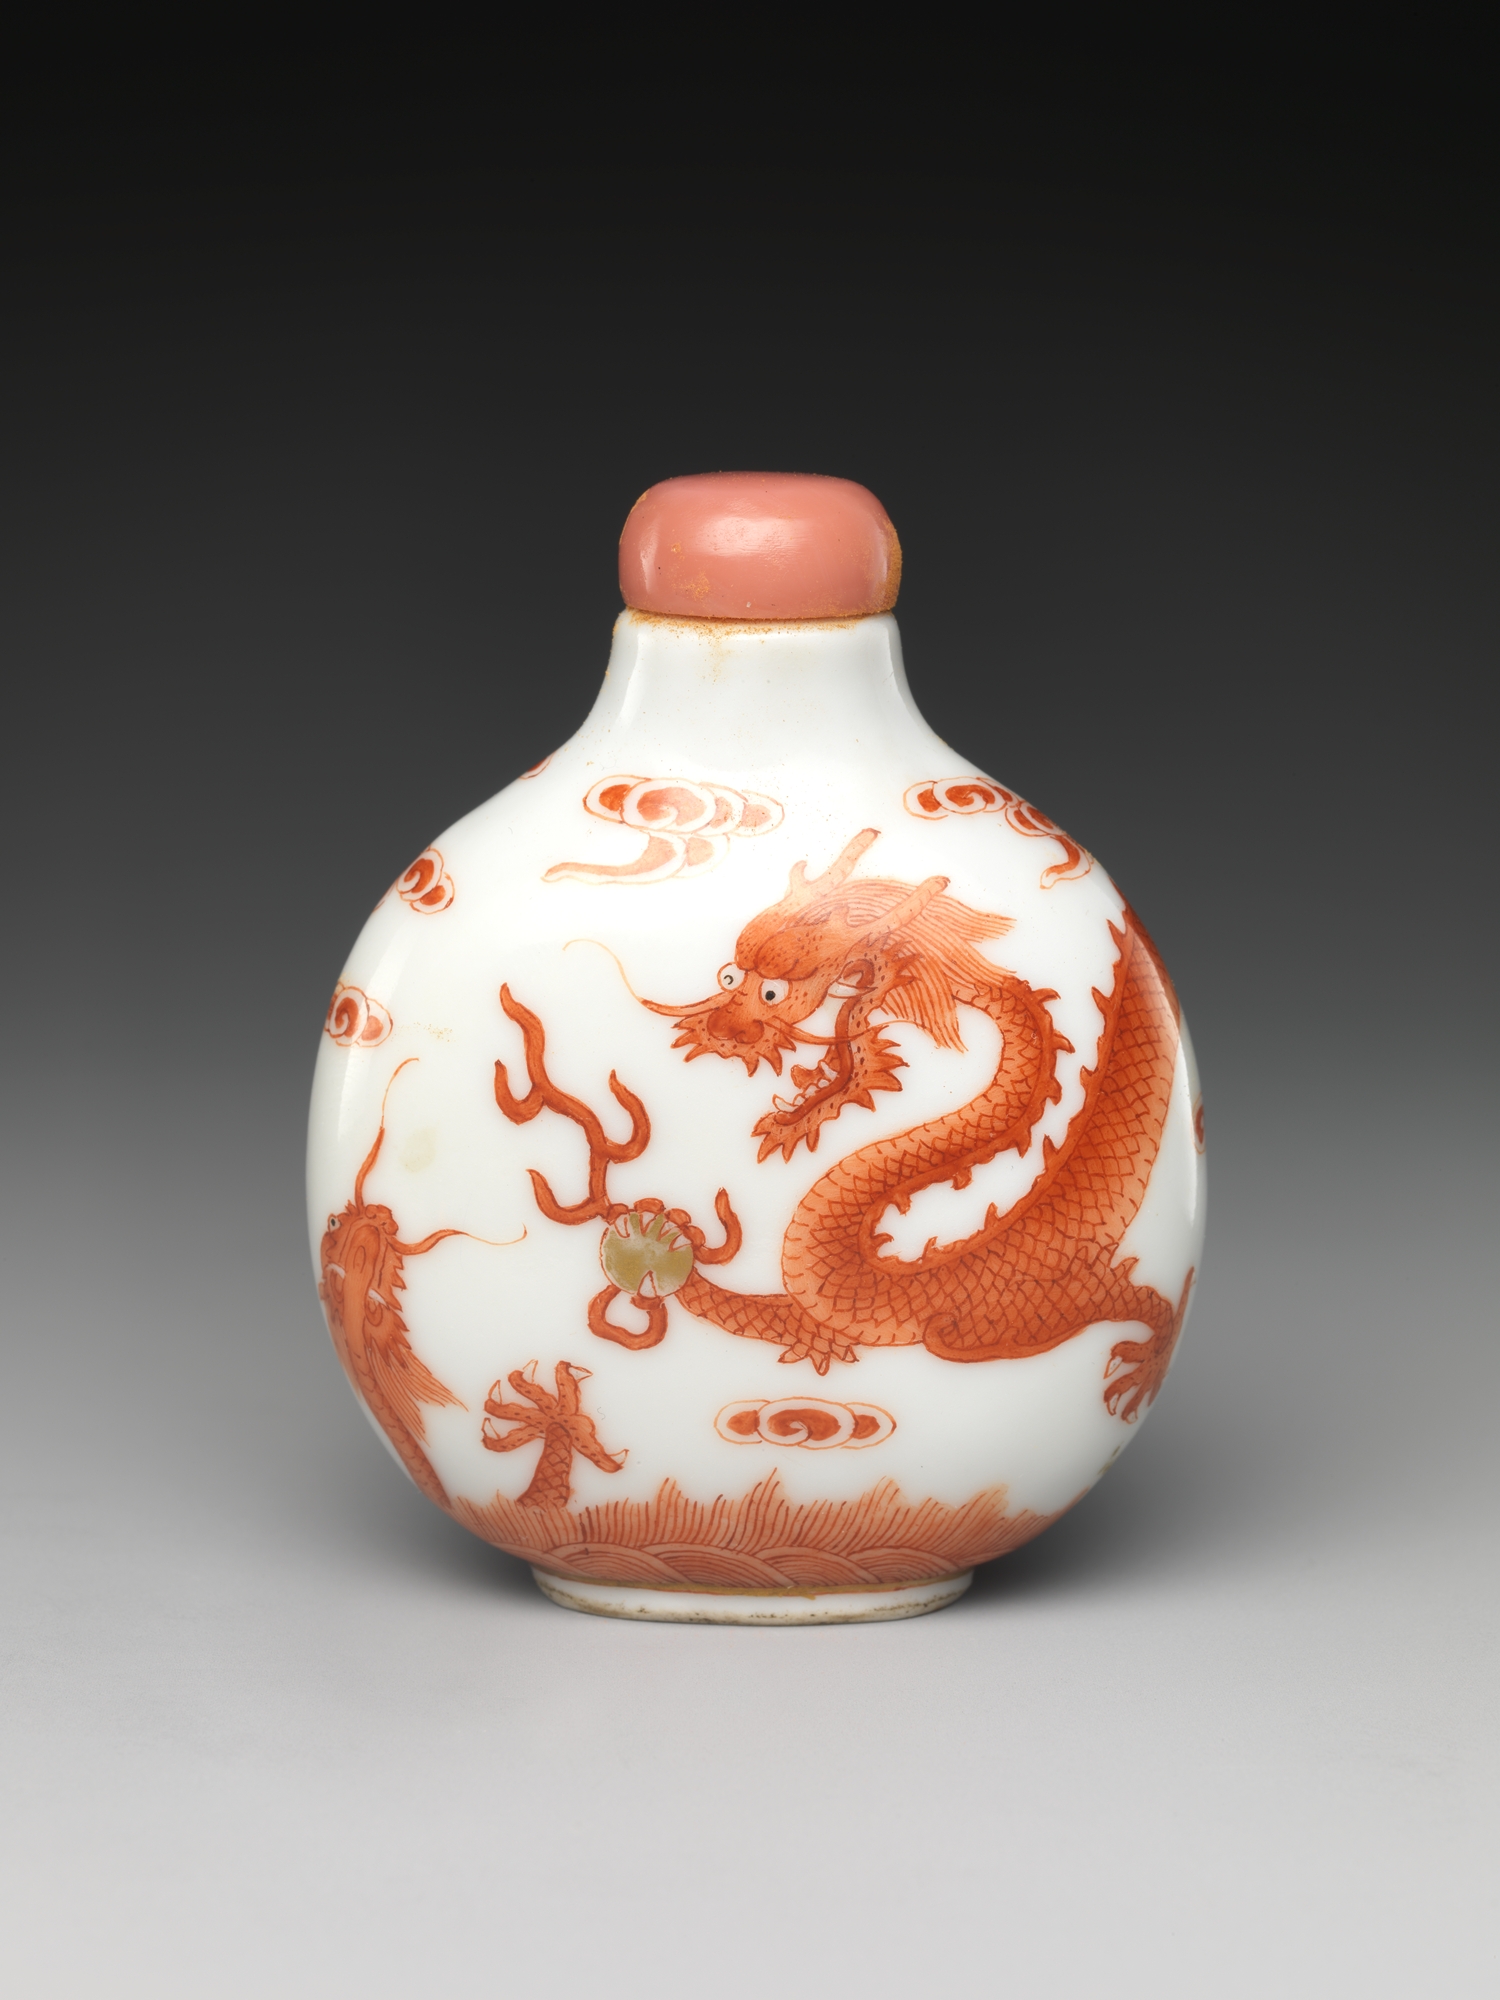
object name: snuff bottle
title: Snuff Bottle with Dragons Chasing Pearl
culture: chinese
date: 1821-1850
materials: coral, porcelain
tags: dragons